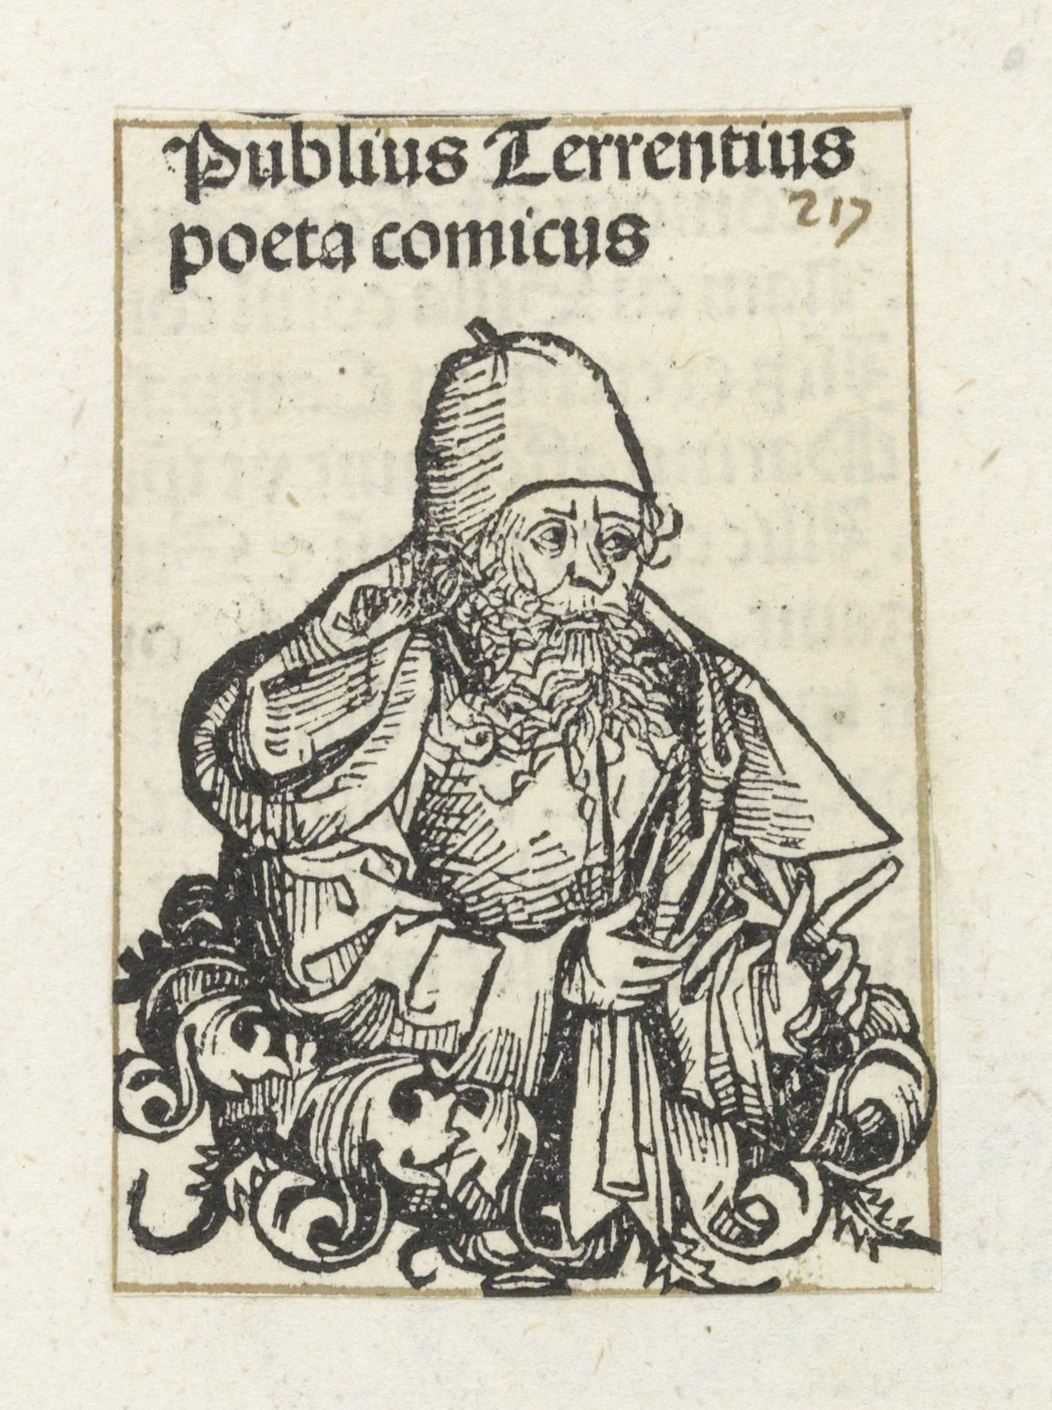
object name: print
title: Liber Chronicarum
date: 1493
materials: paper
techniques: letterpress printing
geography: nuremberg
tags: male persons from classical history, writer, poet, author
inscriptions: inscription: ‘217’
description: De houtsnede wordt gebruikt als boekillustratie in de Liber Chronicarum (of Neurenbergkroniek) van Hartmann Schedel, verschenen in het Latijn en Duits in 1493. Zie de Latijnse uitgave, folio 92v.